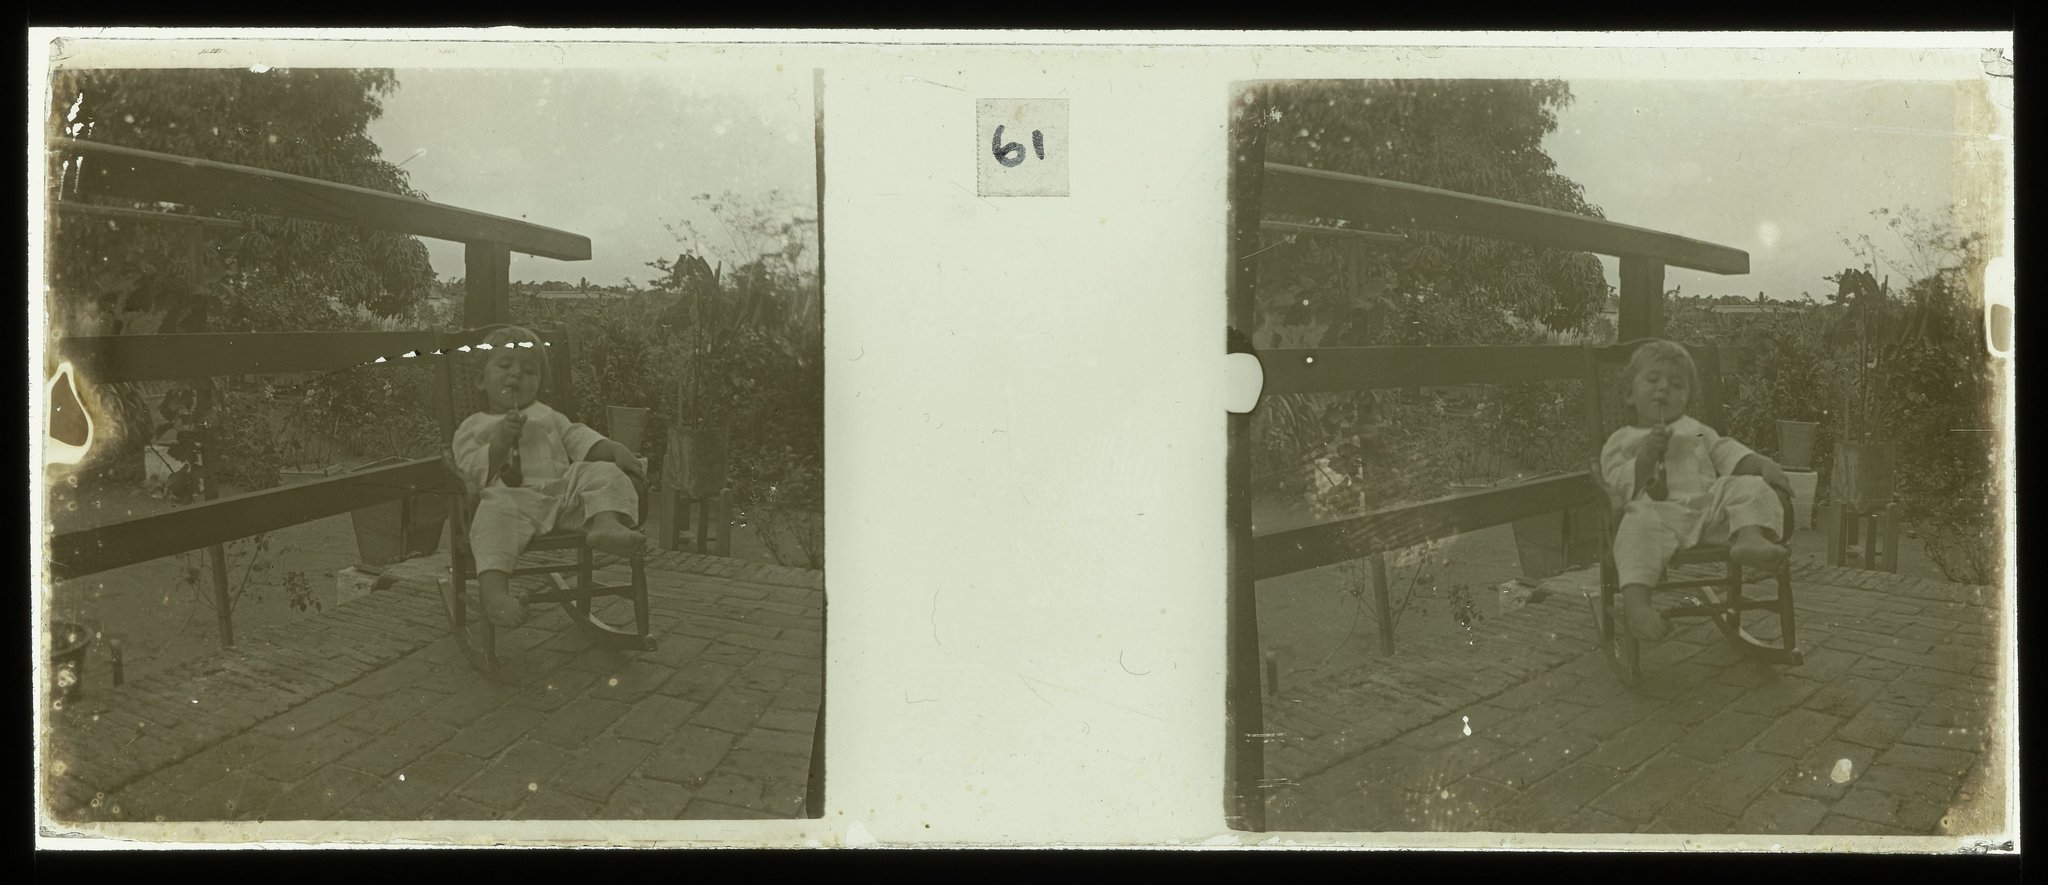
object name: stereograph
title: Gerard Brouwers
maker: theodoor brouwers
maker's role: amateurfotograaf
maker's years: 1874-1932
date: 1913-1930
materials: glass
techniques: photography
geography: suriname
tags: amsterdam, theodoor brouwers, suriname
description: In de periode 1911-1932 woonde op plantage Accaribo in Suriname de familie Brouwers van wie de foto's afkomstig zijn. Rond 1910 vond Theodoor Brouwers werk op plantage Accaribo. In 1929 werd hij eigenaar van de plantage. Op Accaribo werden in zijn tijd bananen geproduceerd en wat koffie.